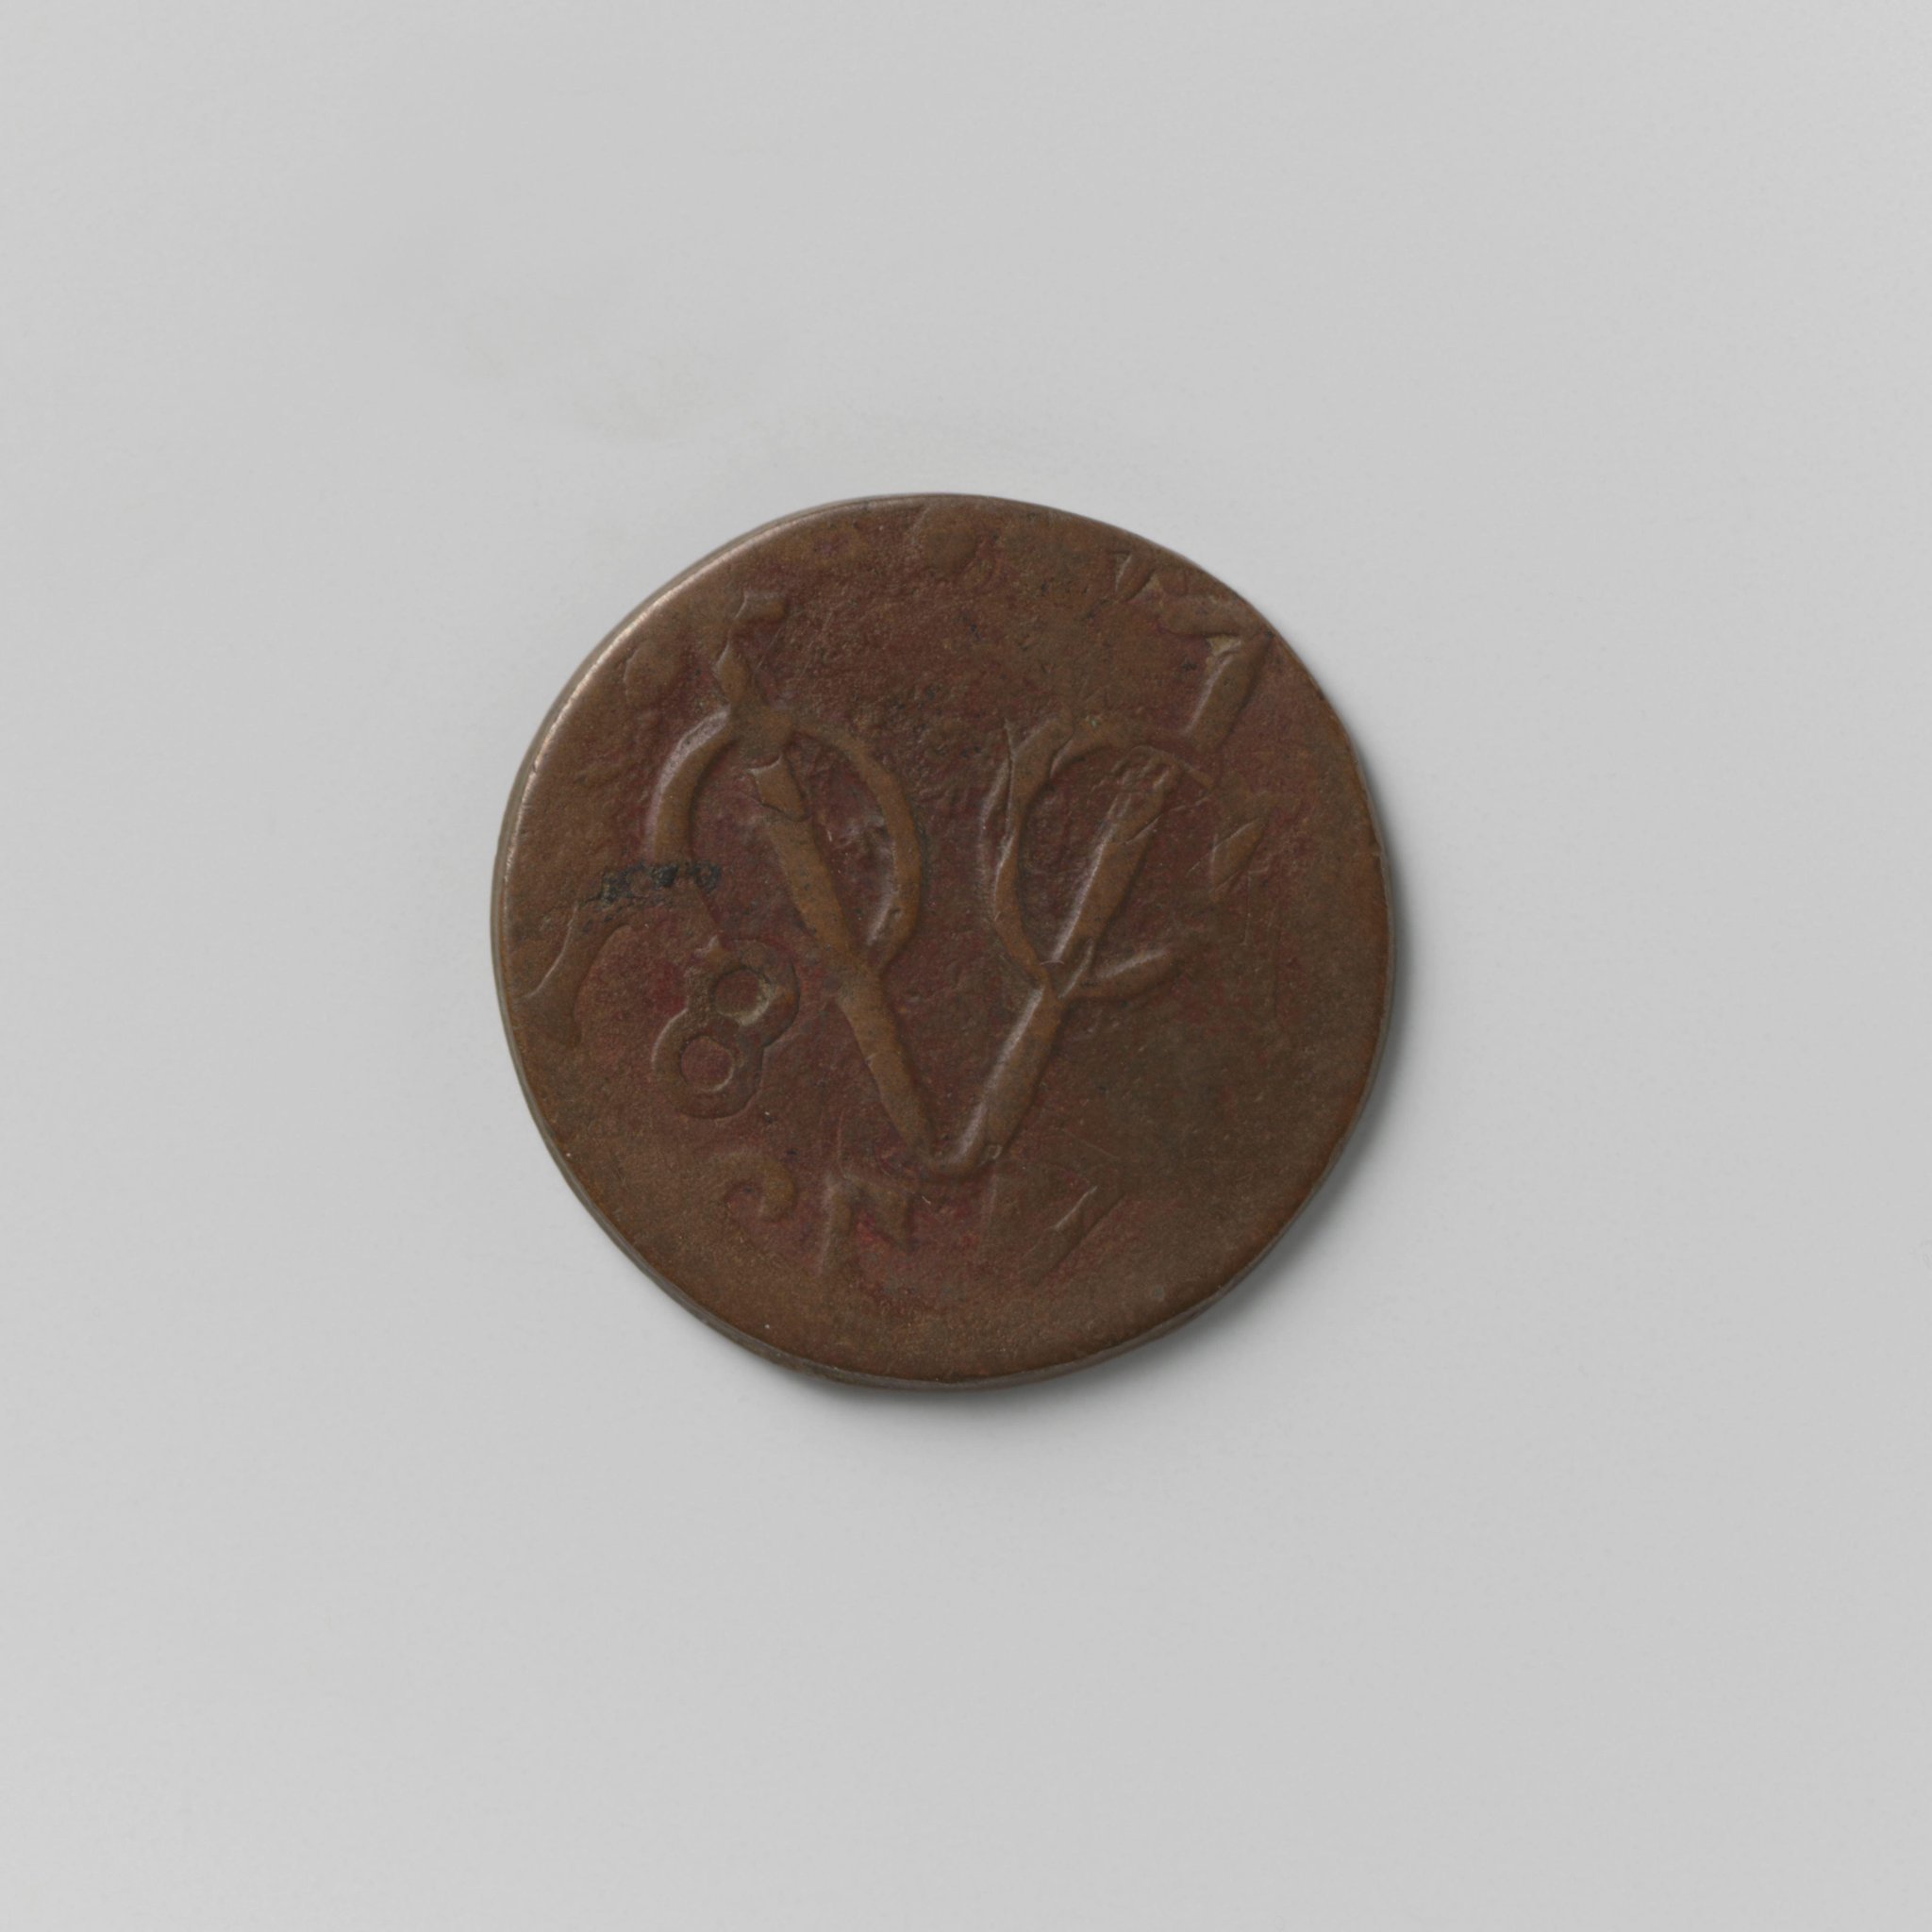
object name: coin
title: Nabootsing van VOC- duit Holland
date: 1780-1830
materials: copper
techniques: striking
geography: banjarmasin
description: Koperen munt. Nabootsing van duit van de VOC uit Holland. Voorzijde: gekroond wapenschild van Holland. Keerzijde: monogram van de VOC, waarboven punt en waaronder fictief jaartal.